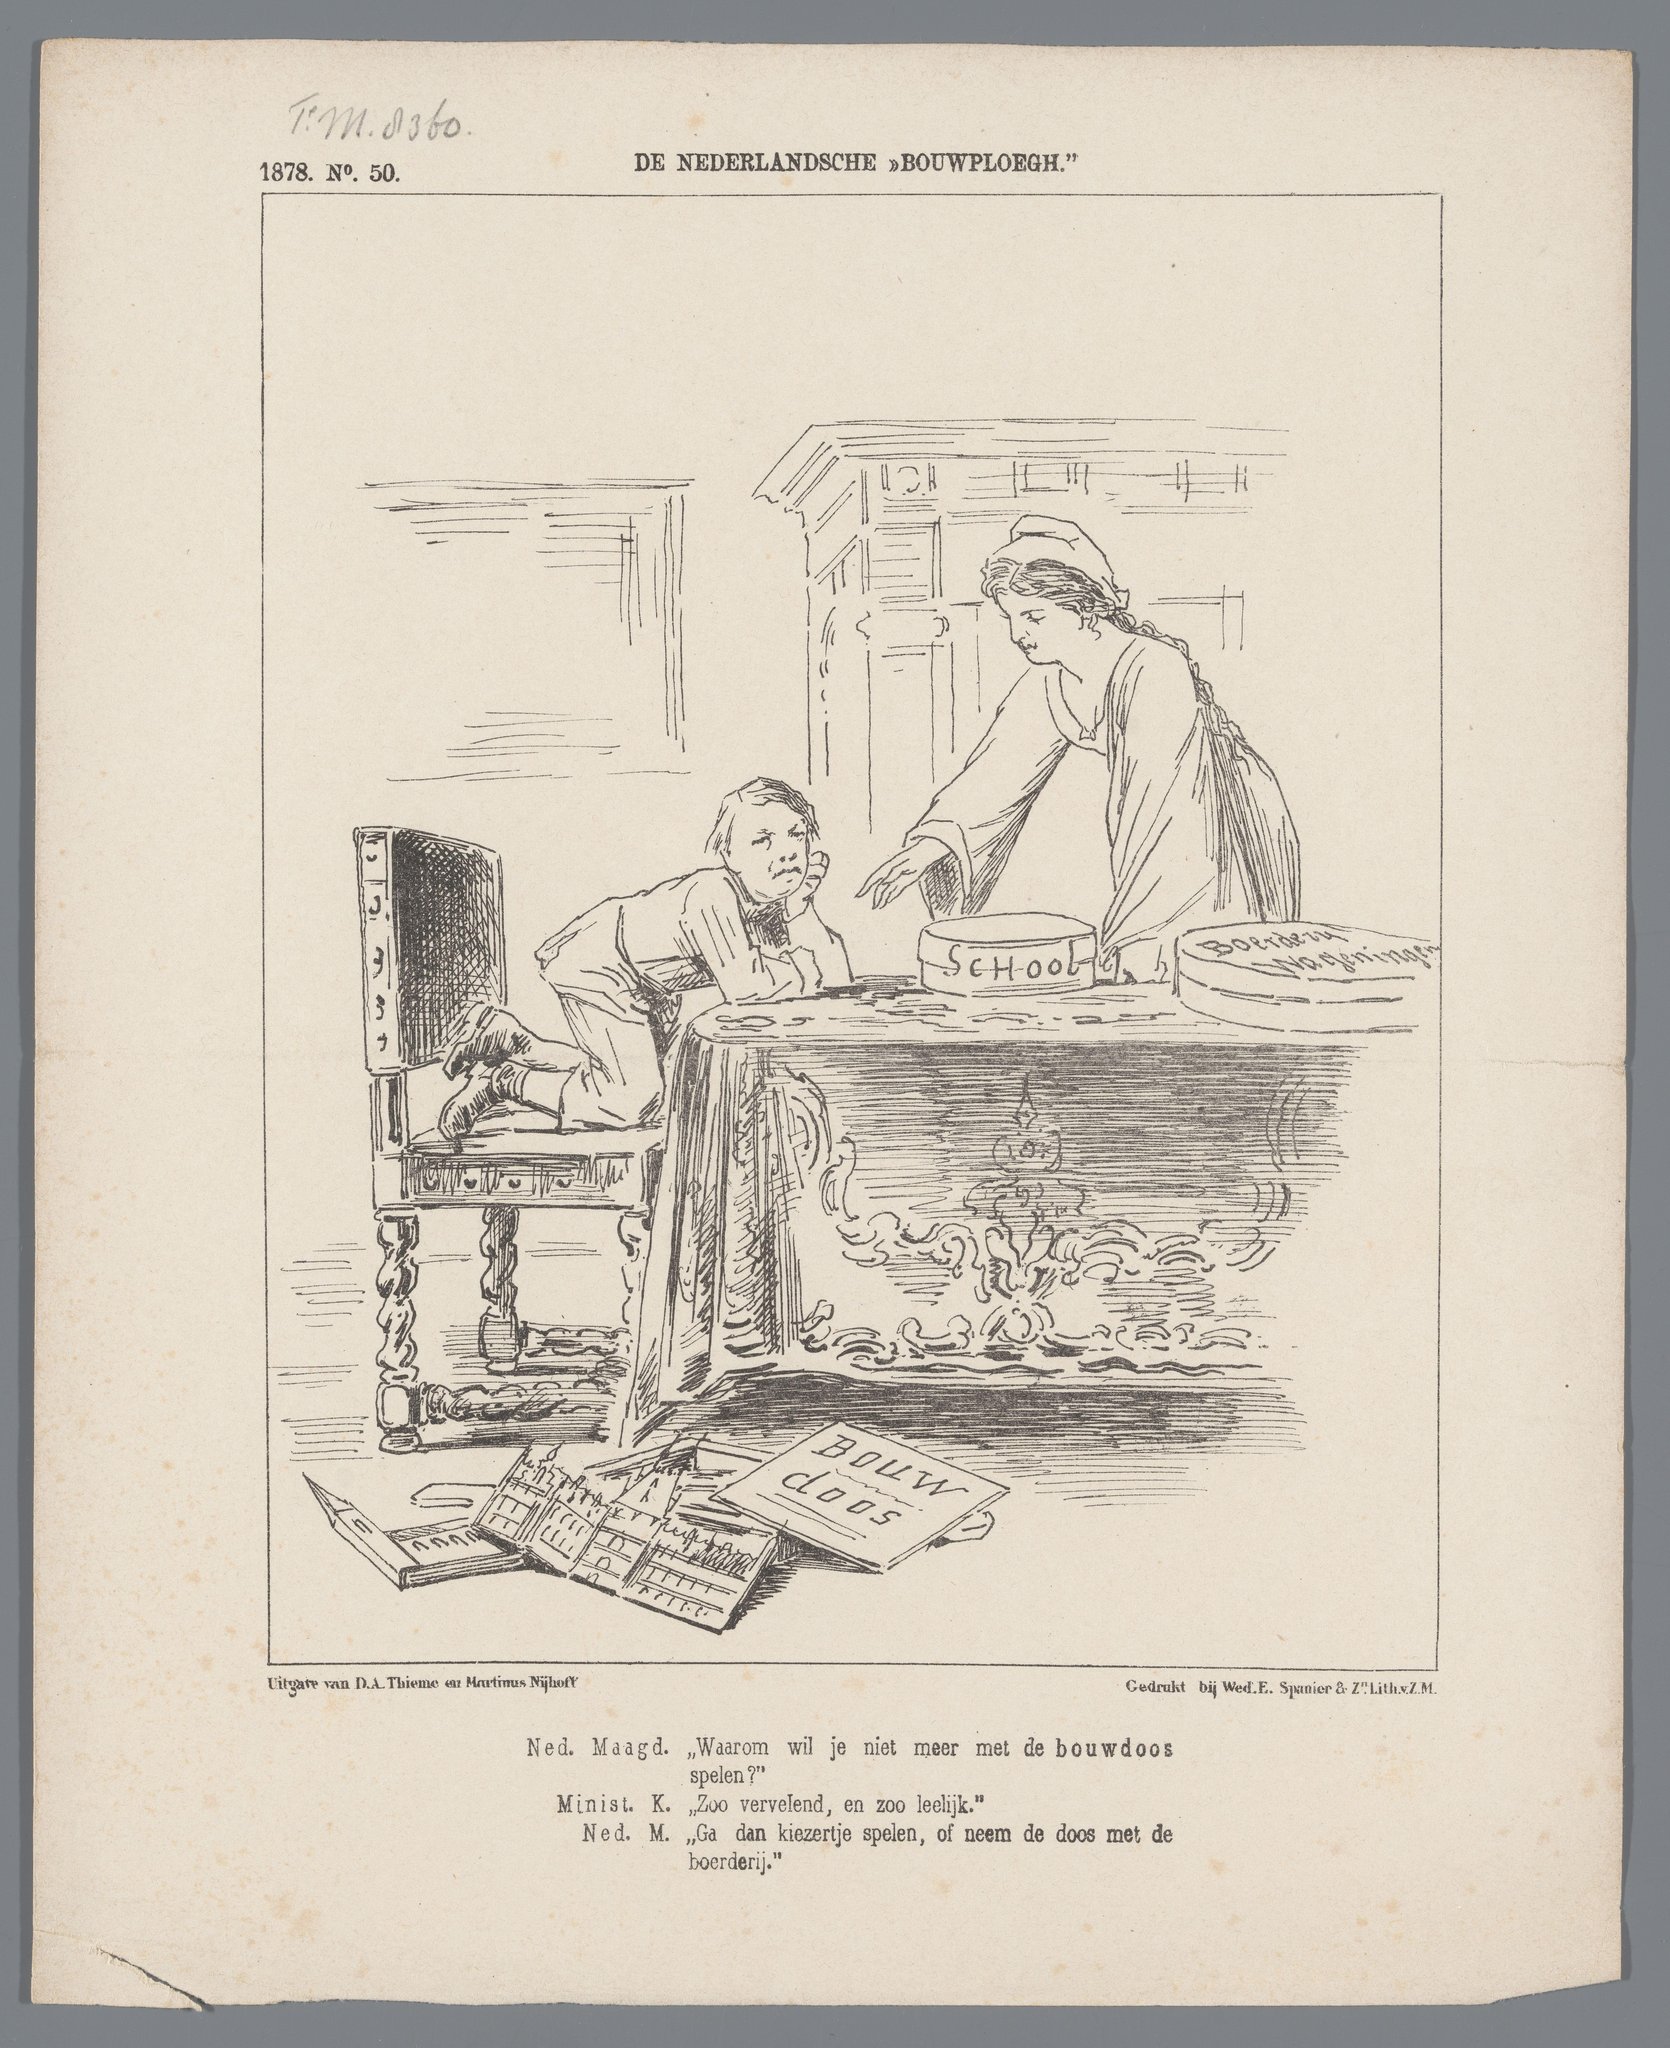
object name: cartoon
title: De Nederlandsche "bouwploegh"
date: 1878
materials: paper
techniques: lithograph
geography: arnhem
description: Spotprent. Plaat verschenen bij het weekblad De Nederlandsche Spectator, nr. 50, 1878.